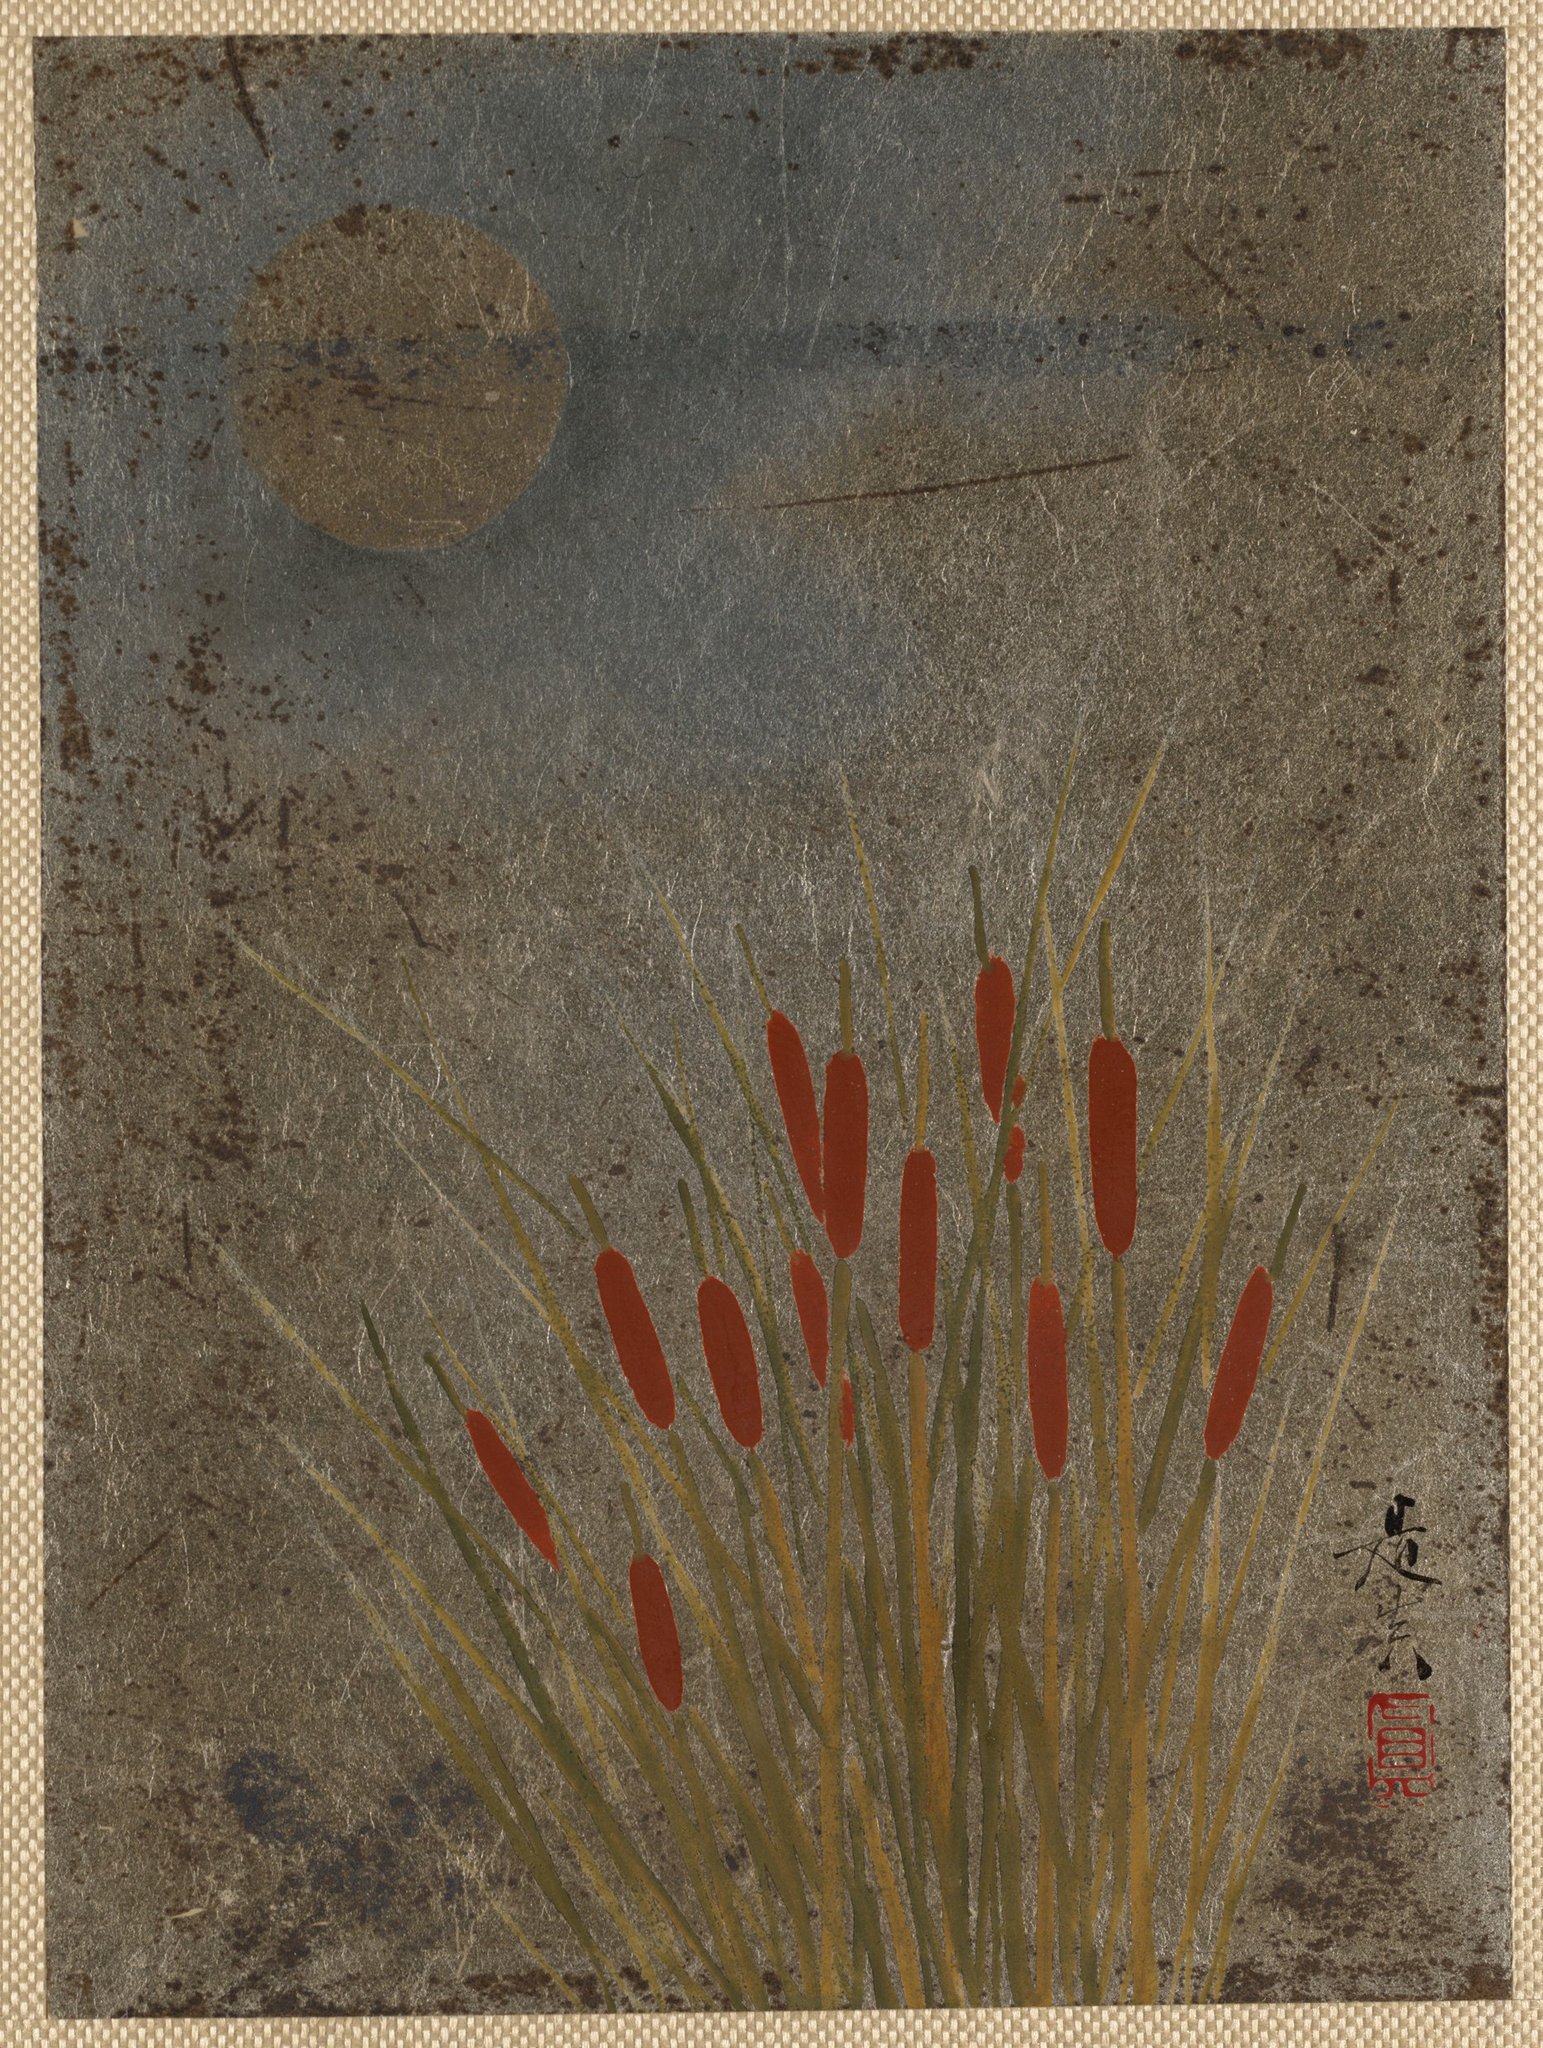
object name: album leaf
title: Cat Tails and Moon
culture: japanese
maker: shibata zeshin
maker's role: artist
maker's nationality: japanese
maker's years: 1807-1891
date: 1807-1868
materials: lacquer, paper, silver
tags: moon,plants